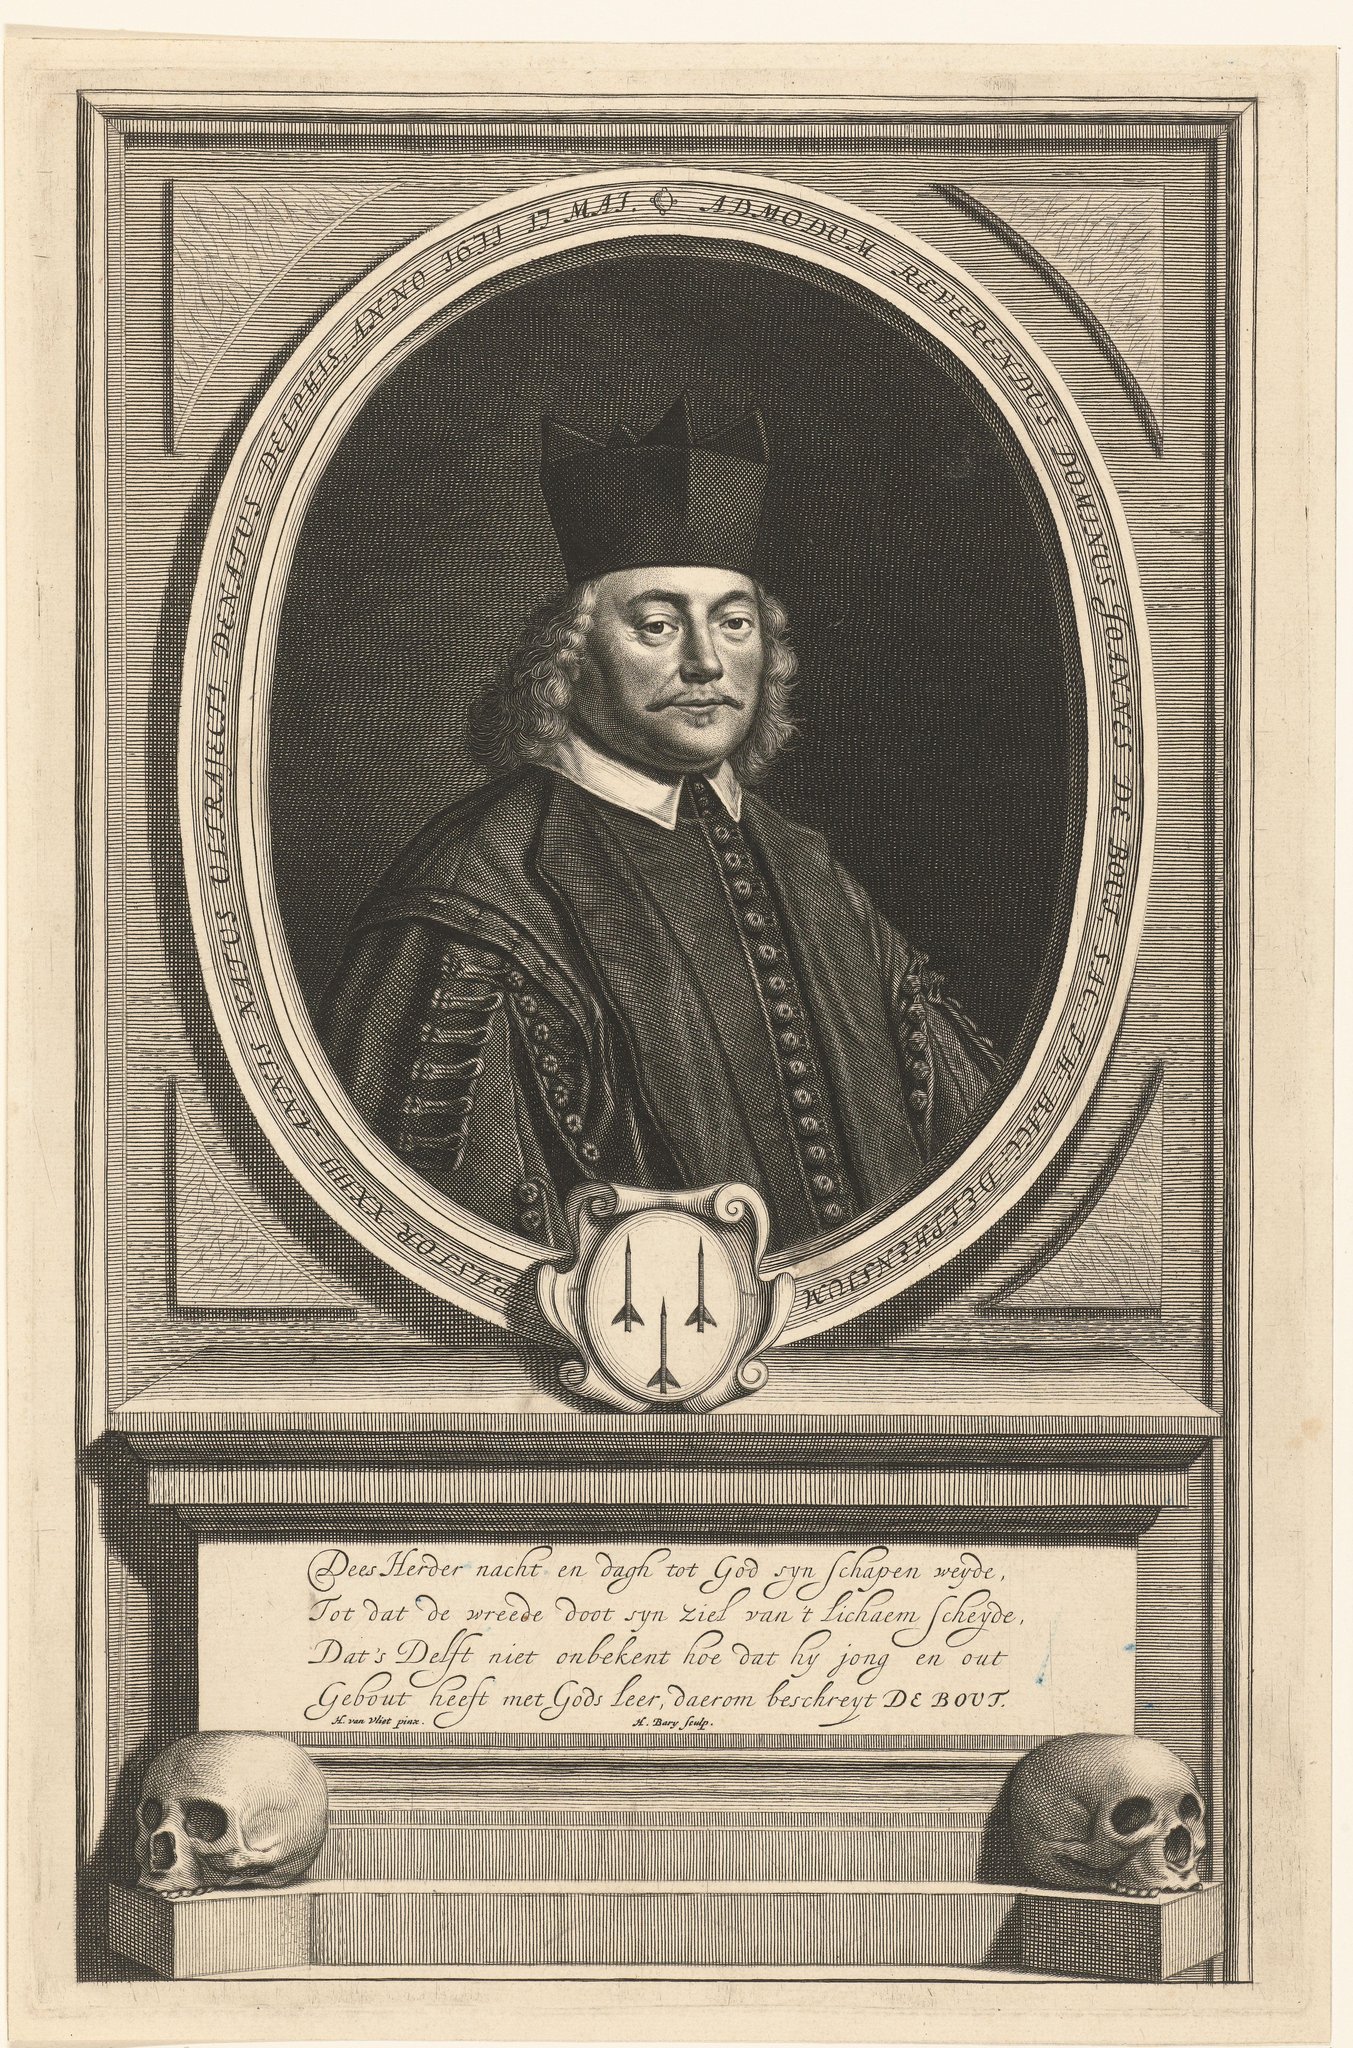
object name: print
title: Portret van Johannes de Bout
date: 1677-1679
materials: paper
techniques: engraving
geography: netherlands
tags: utrecht, delft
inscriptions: collector's mark: Lugt 2228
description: Borstbeeld van pastoor Johannes de Bout in ovaal. Onder het portret een wapen en een vers van vier regels in het Nederlands op het overlijden van De Bout.